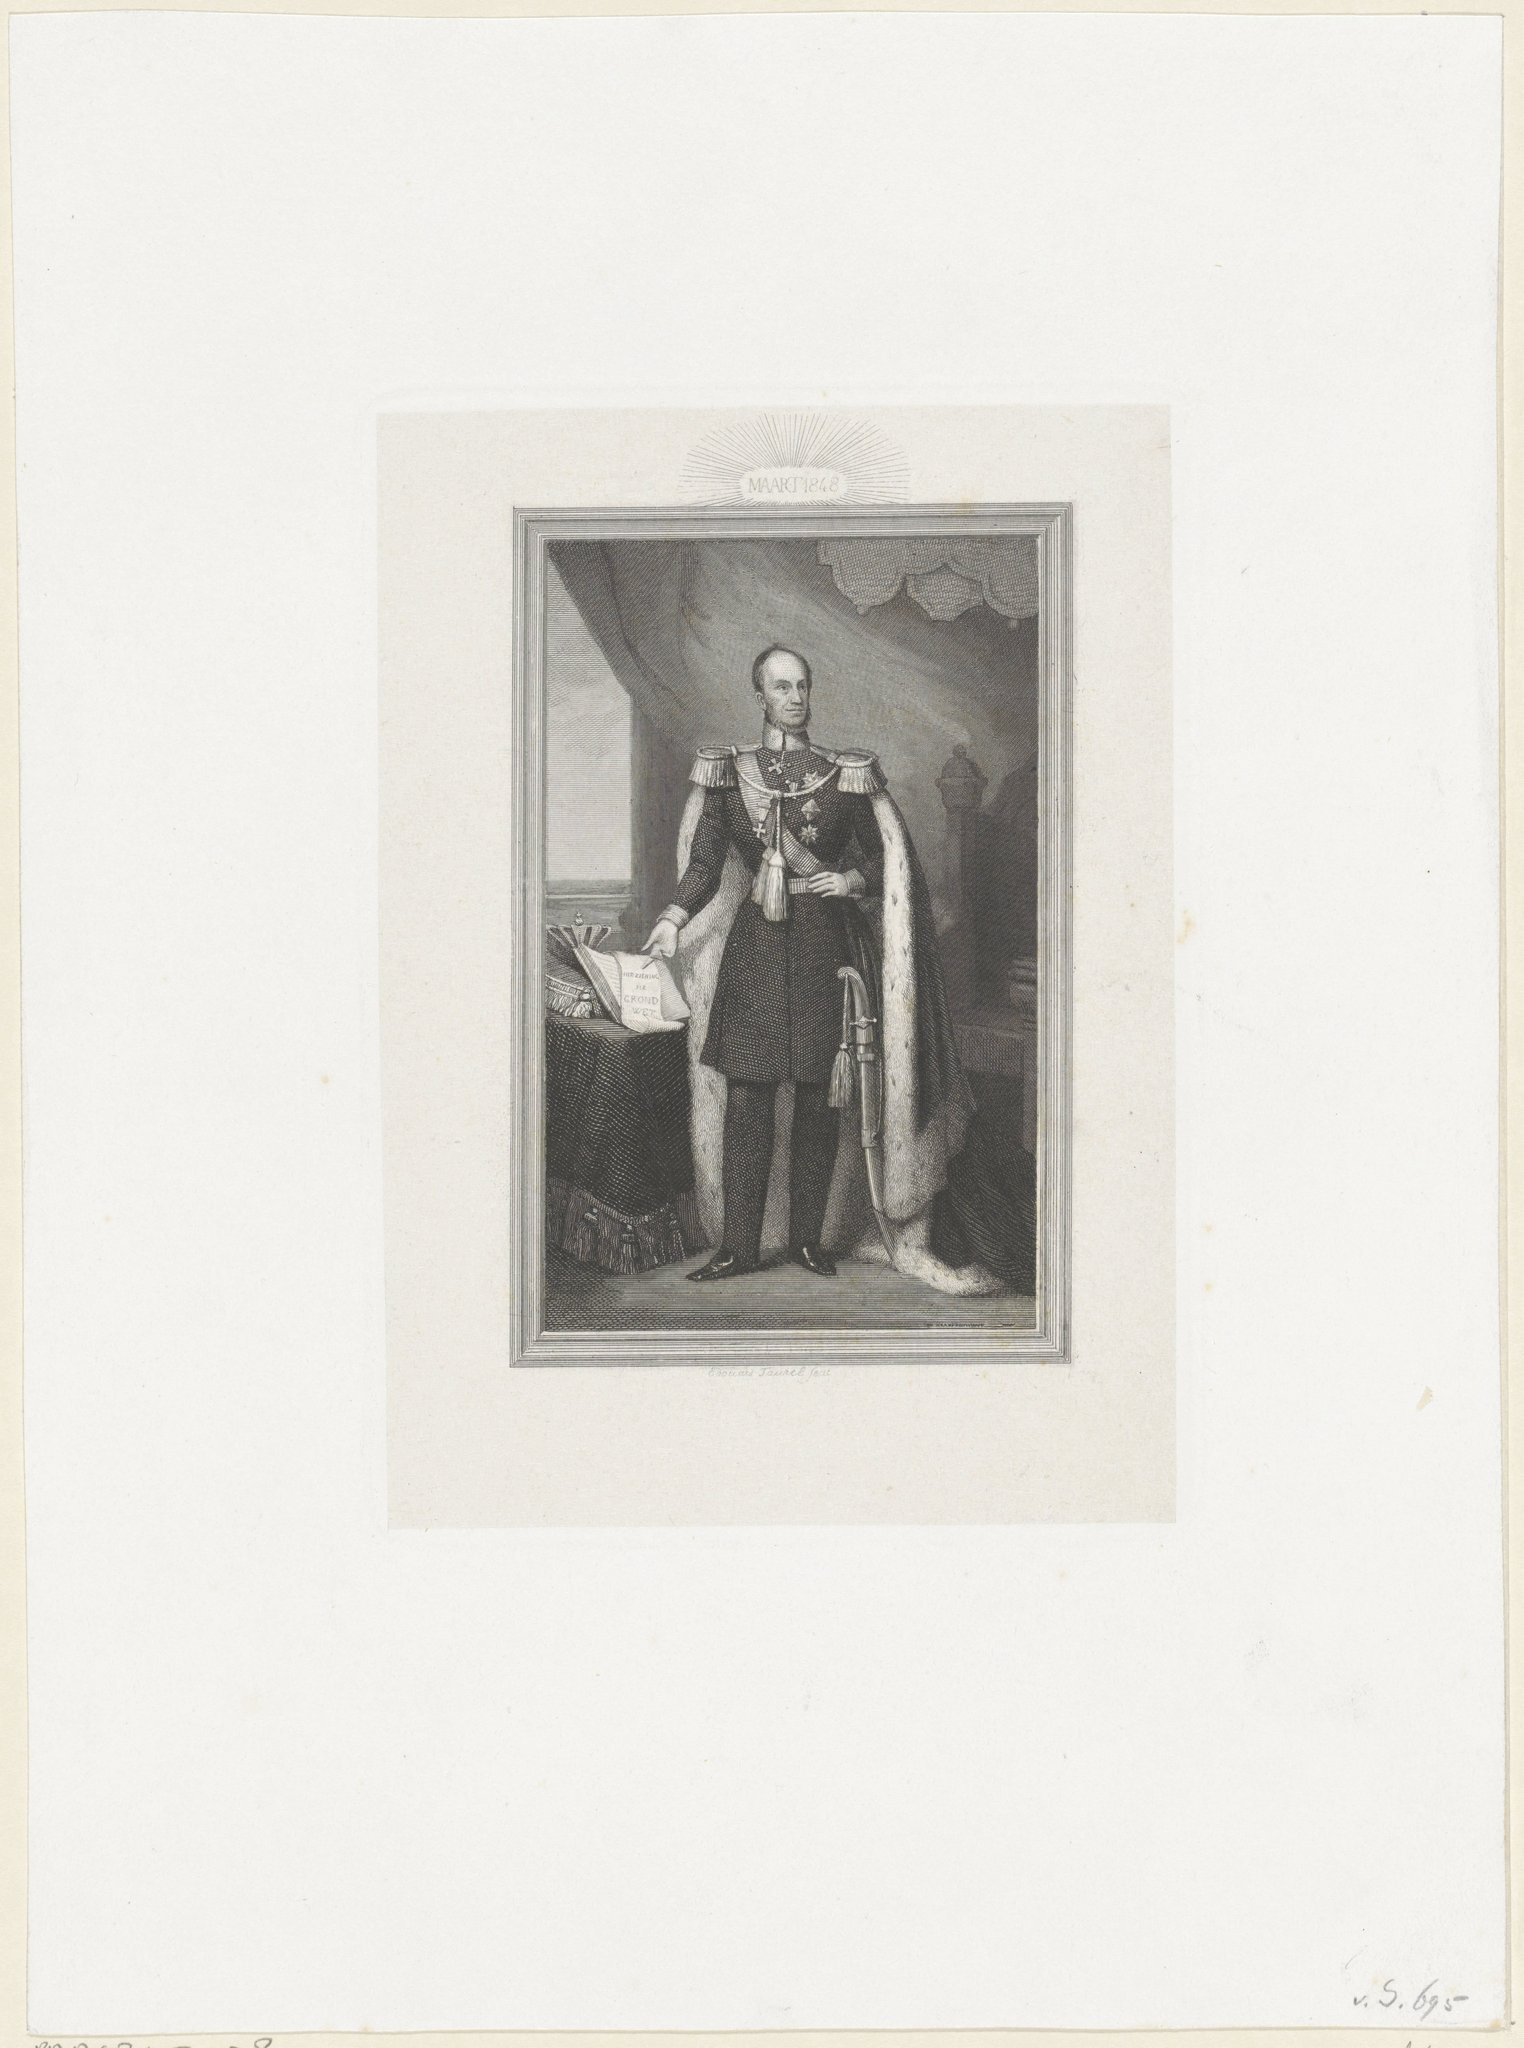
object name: print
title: Portret van Willem II, koning der Nederlanden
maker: edouard taurel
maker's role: draughtsman, print maker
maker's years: 1824-1892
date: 1848-1892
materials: paper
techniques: engraving, etching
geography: amsterdam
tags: william ii of the netherlands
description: Portret van Willem II met een hermelijnen mantel. Hij staat in een vertrek naast een tafel met daarop zijn kroon en wijst met zijn rechterhand naar de herziening van de Nederlandse grondwet. Midden boven 'MAART 1848'.